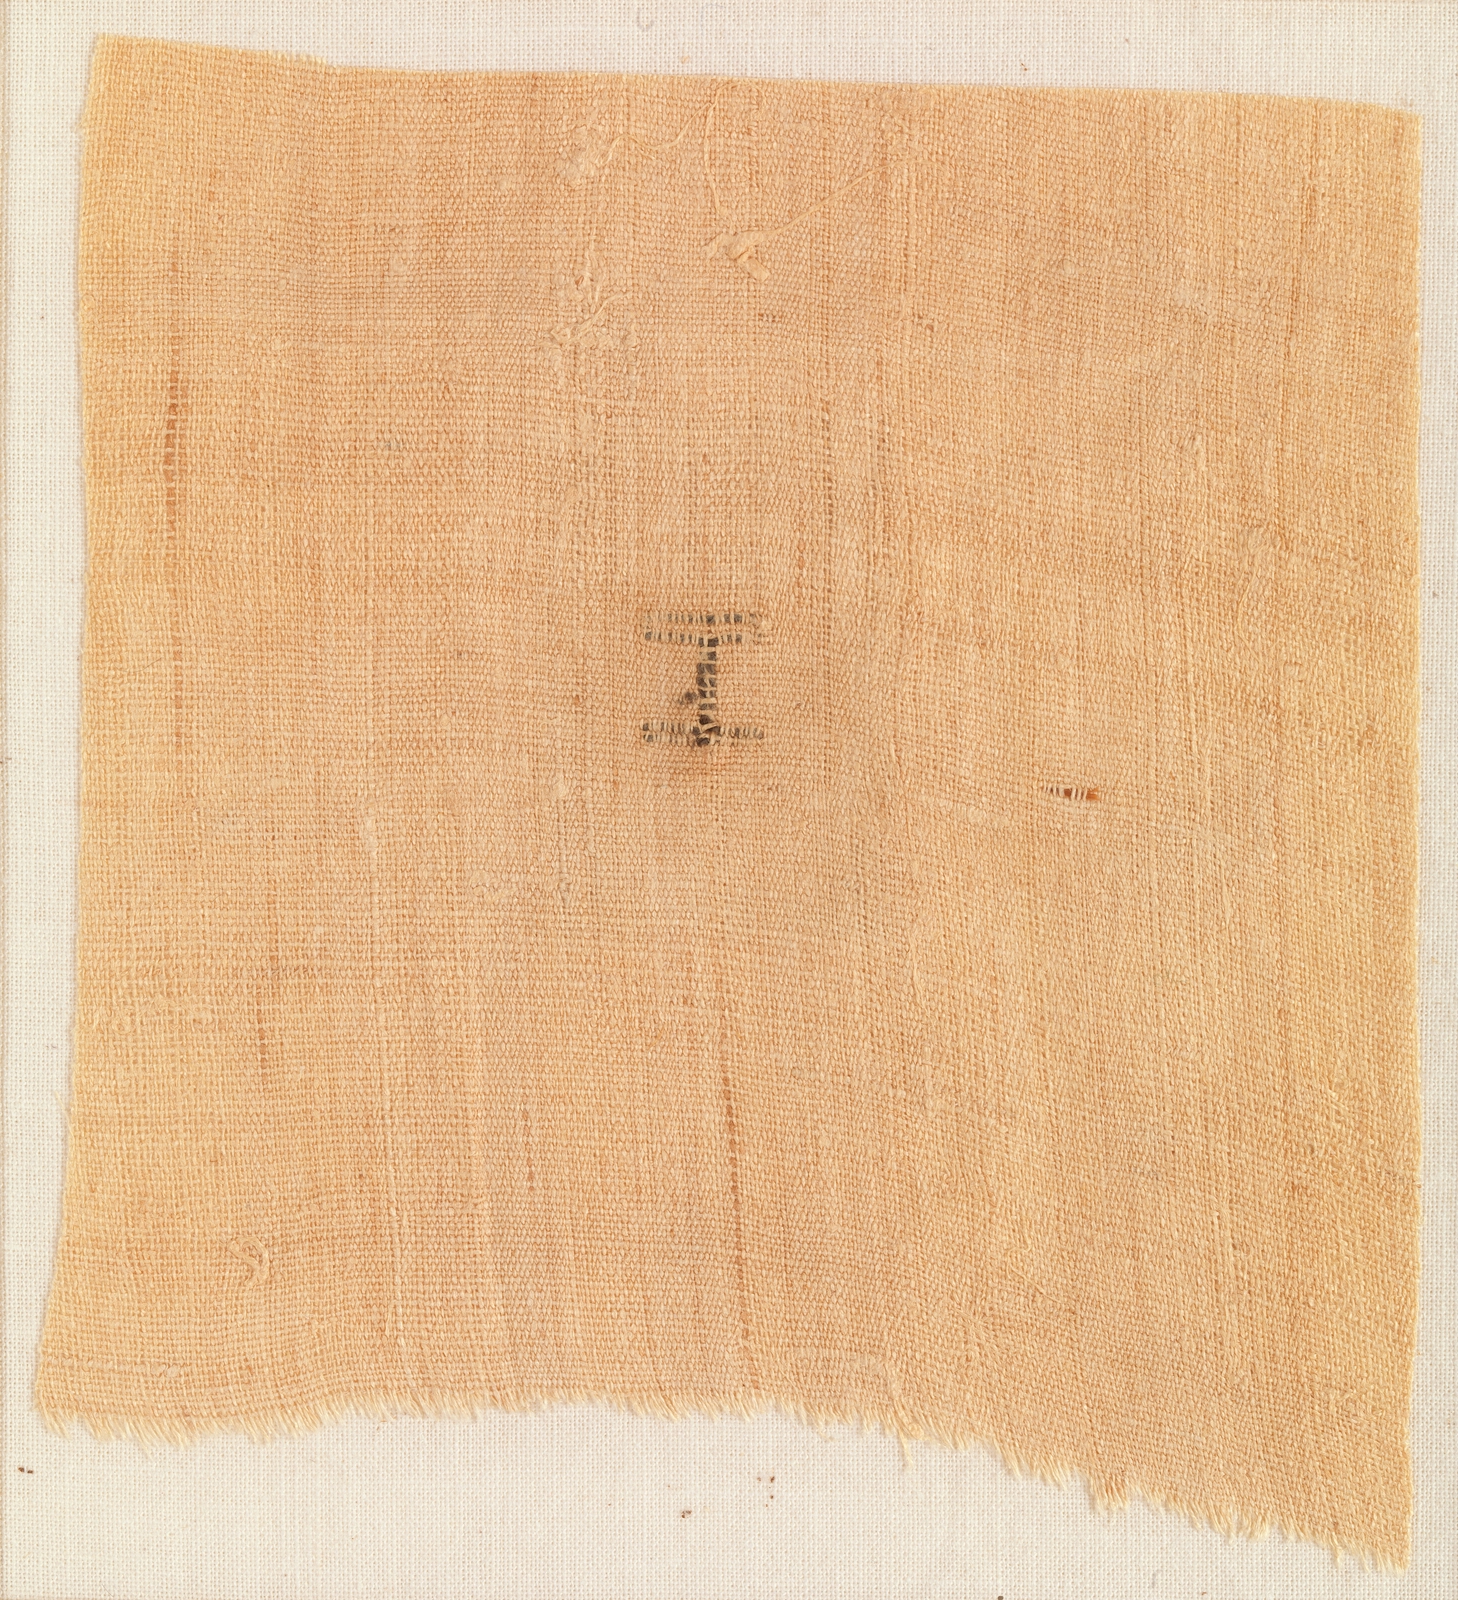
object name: linen mark, wah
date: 1981-1975 BCE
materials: linen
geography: egypt